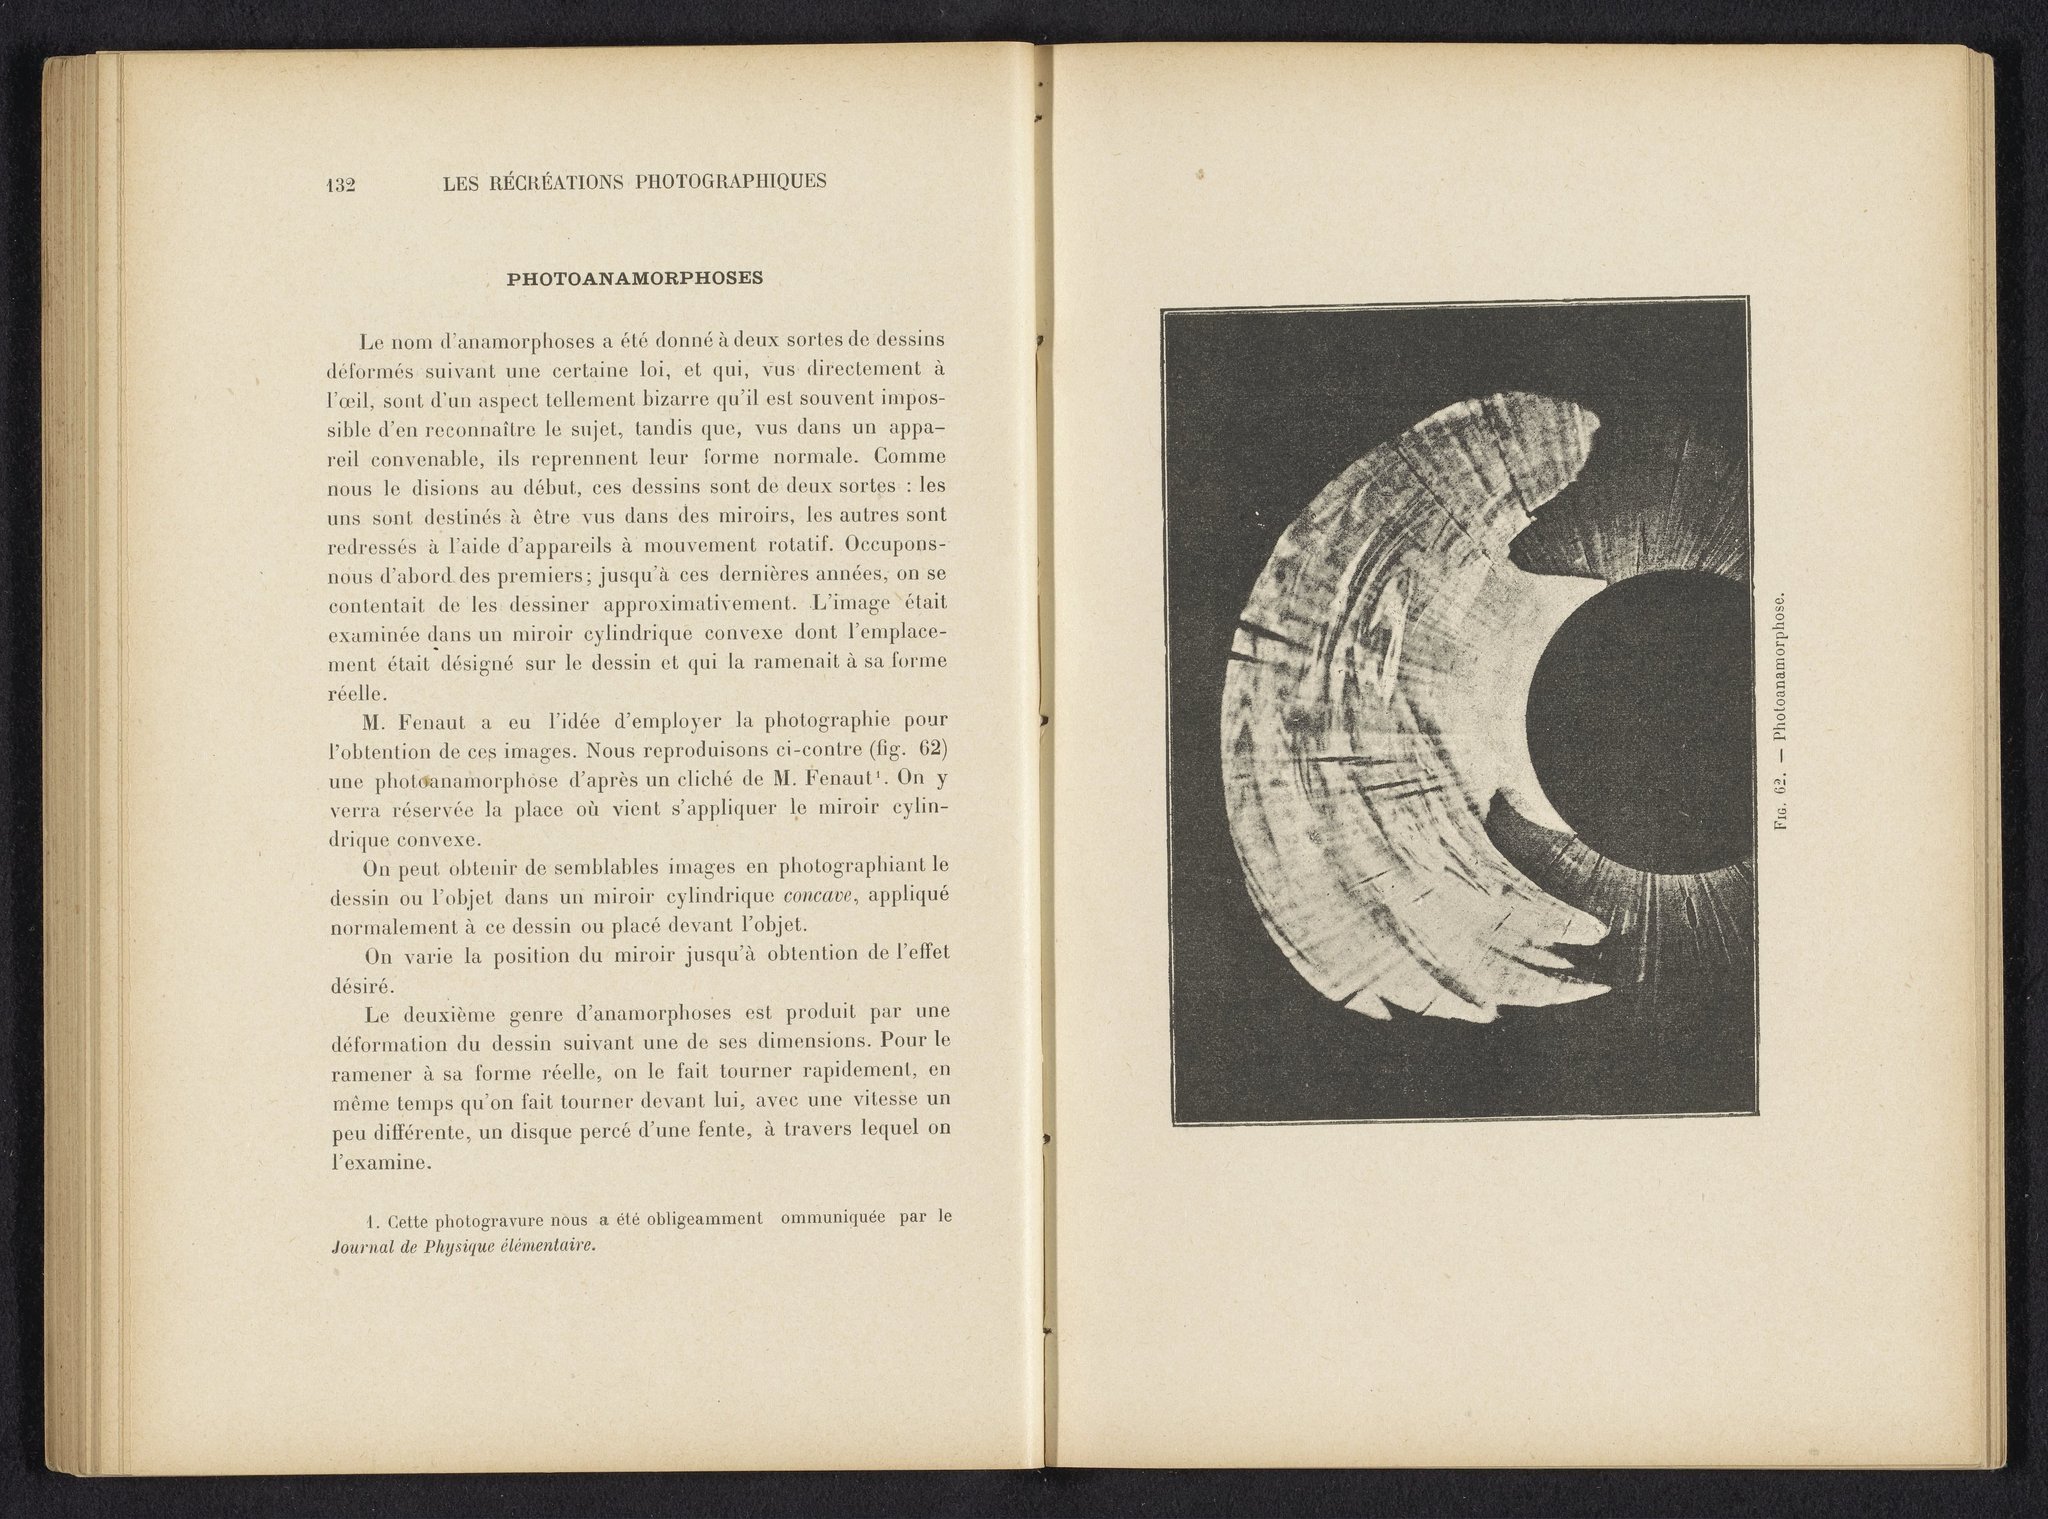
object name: page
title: Photoanamorphose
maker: Anonymous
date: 1883-1893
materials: paper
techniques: autotype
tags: photography, cinematography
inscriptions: number: ‘Fig. 62.’